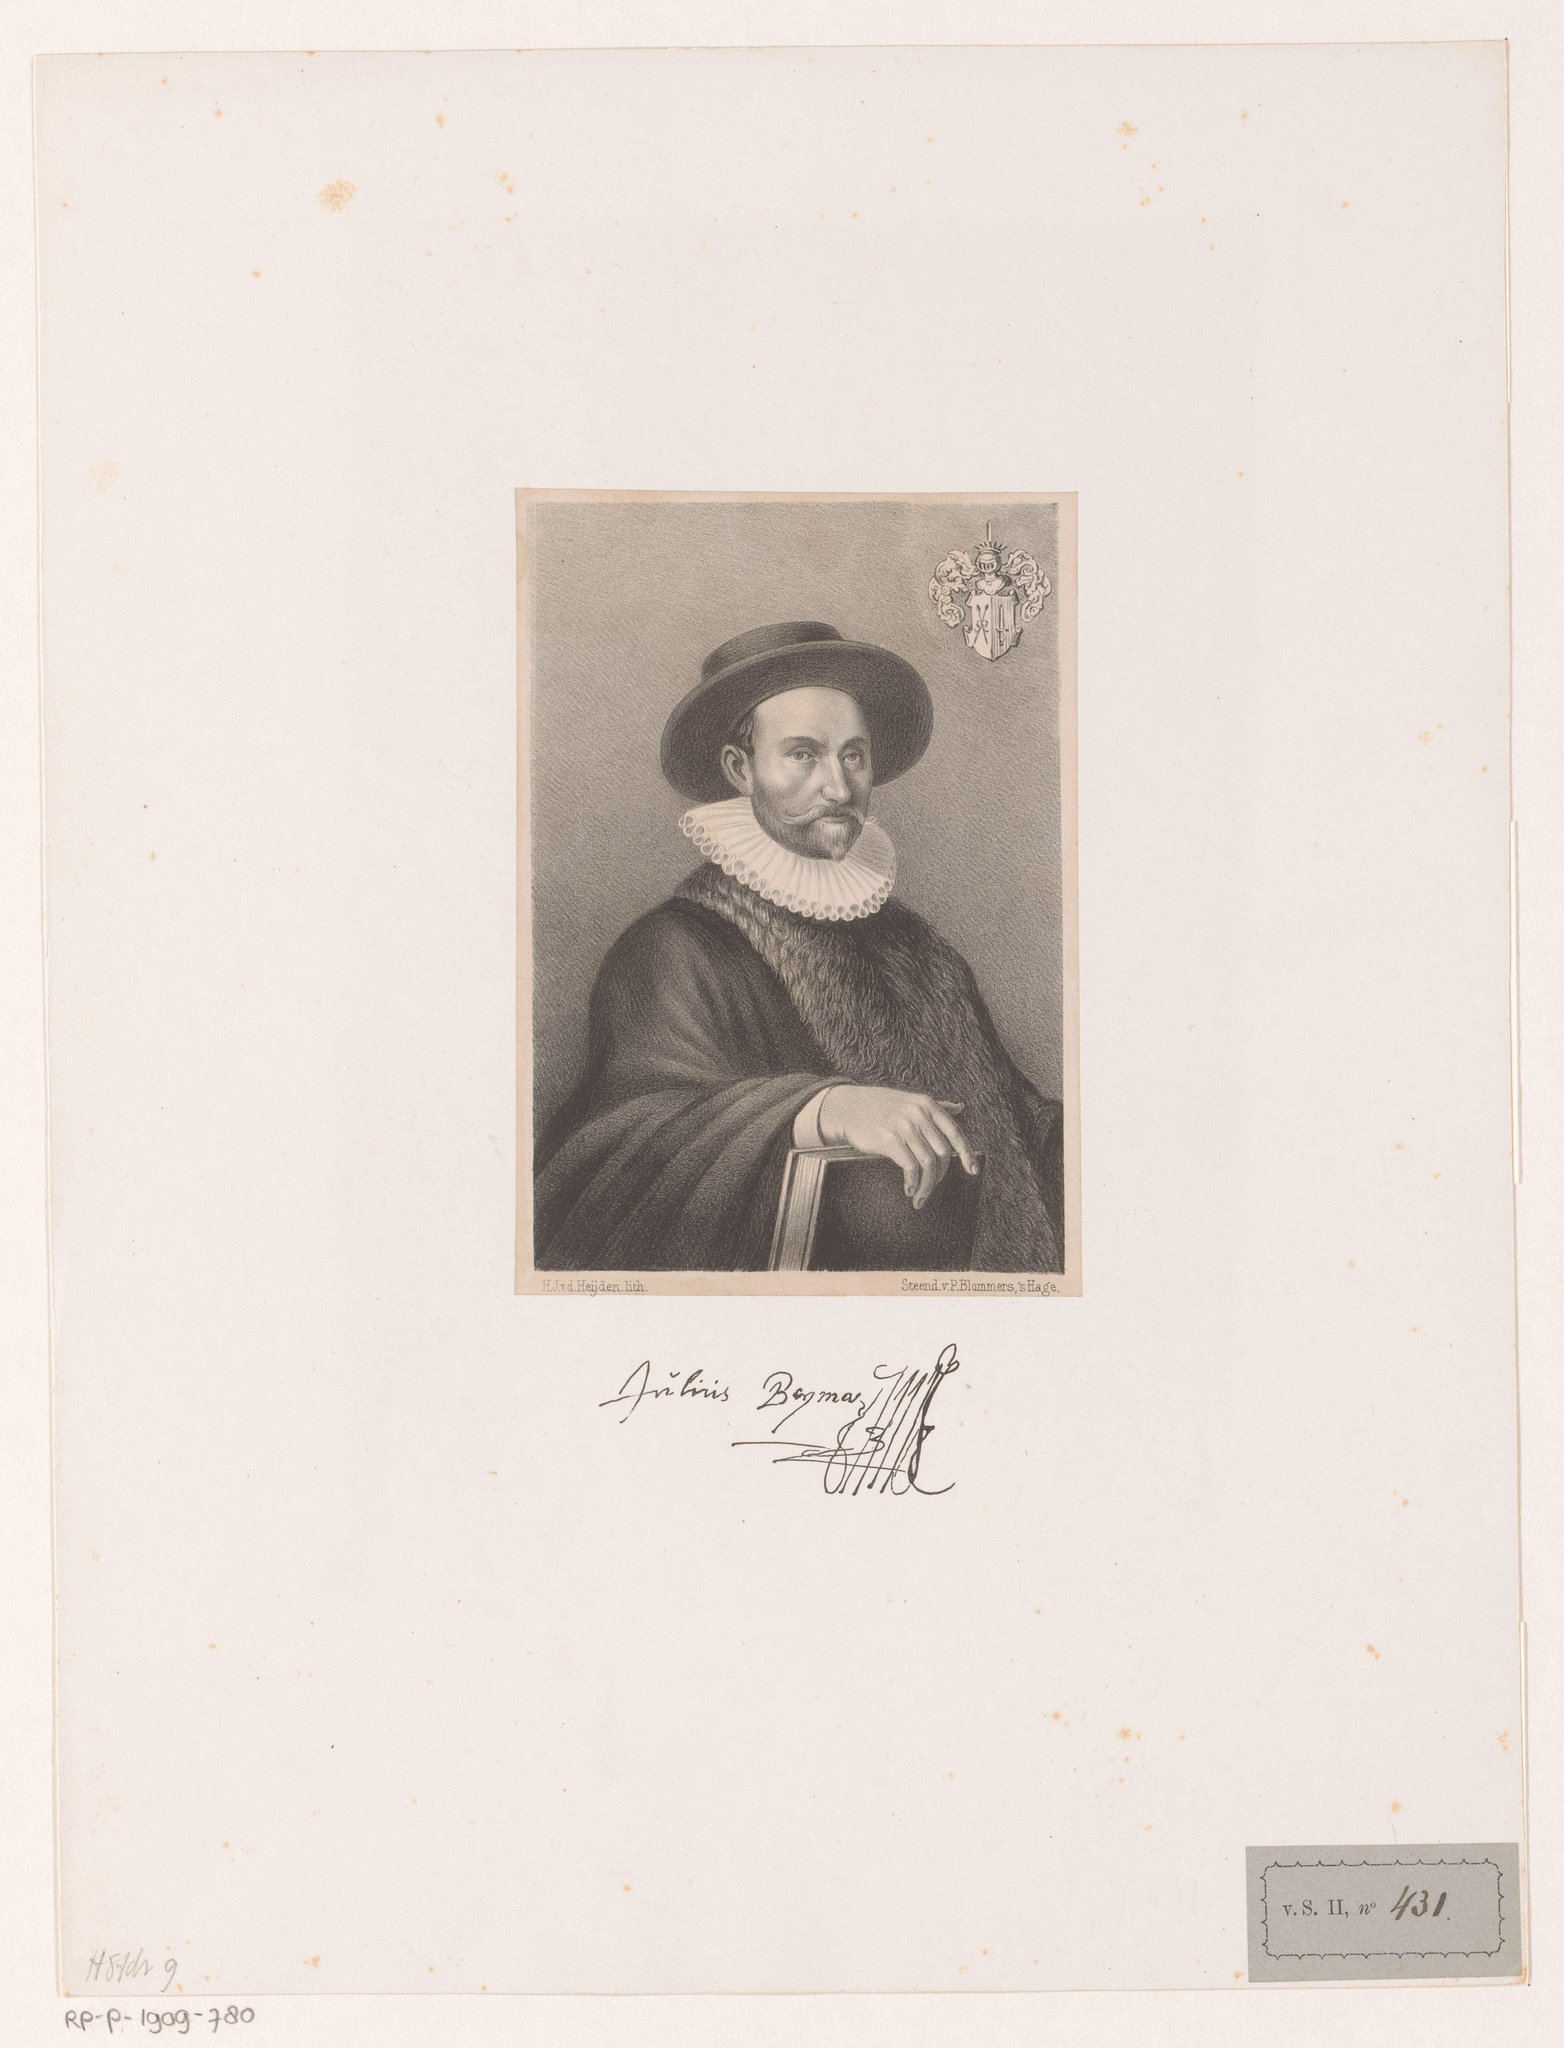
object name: print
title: Portret van Jul. à Beijma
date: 1842-1887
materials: paper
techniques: lithograph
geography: netherlands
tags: neck-gear ~ clothing (with name), book, historical persons (+ half-length portrait)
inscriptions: collector's mark: Lugt 2228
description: De geportretteerde draagt een hoed, plooikraag en een mantel afgezet met bont. Zijn rechterarm leunt op een gesloten boek. Rechtsboven een wapenschild. Onder het portret zijn signatuur.